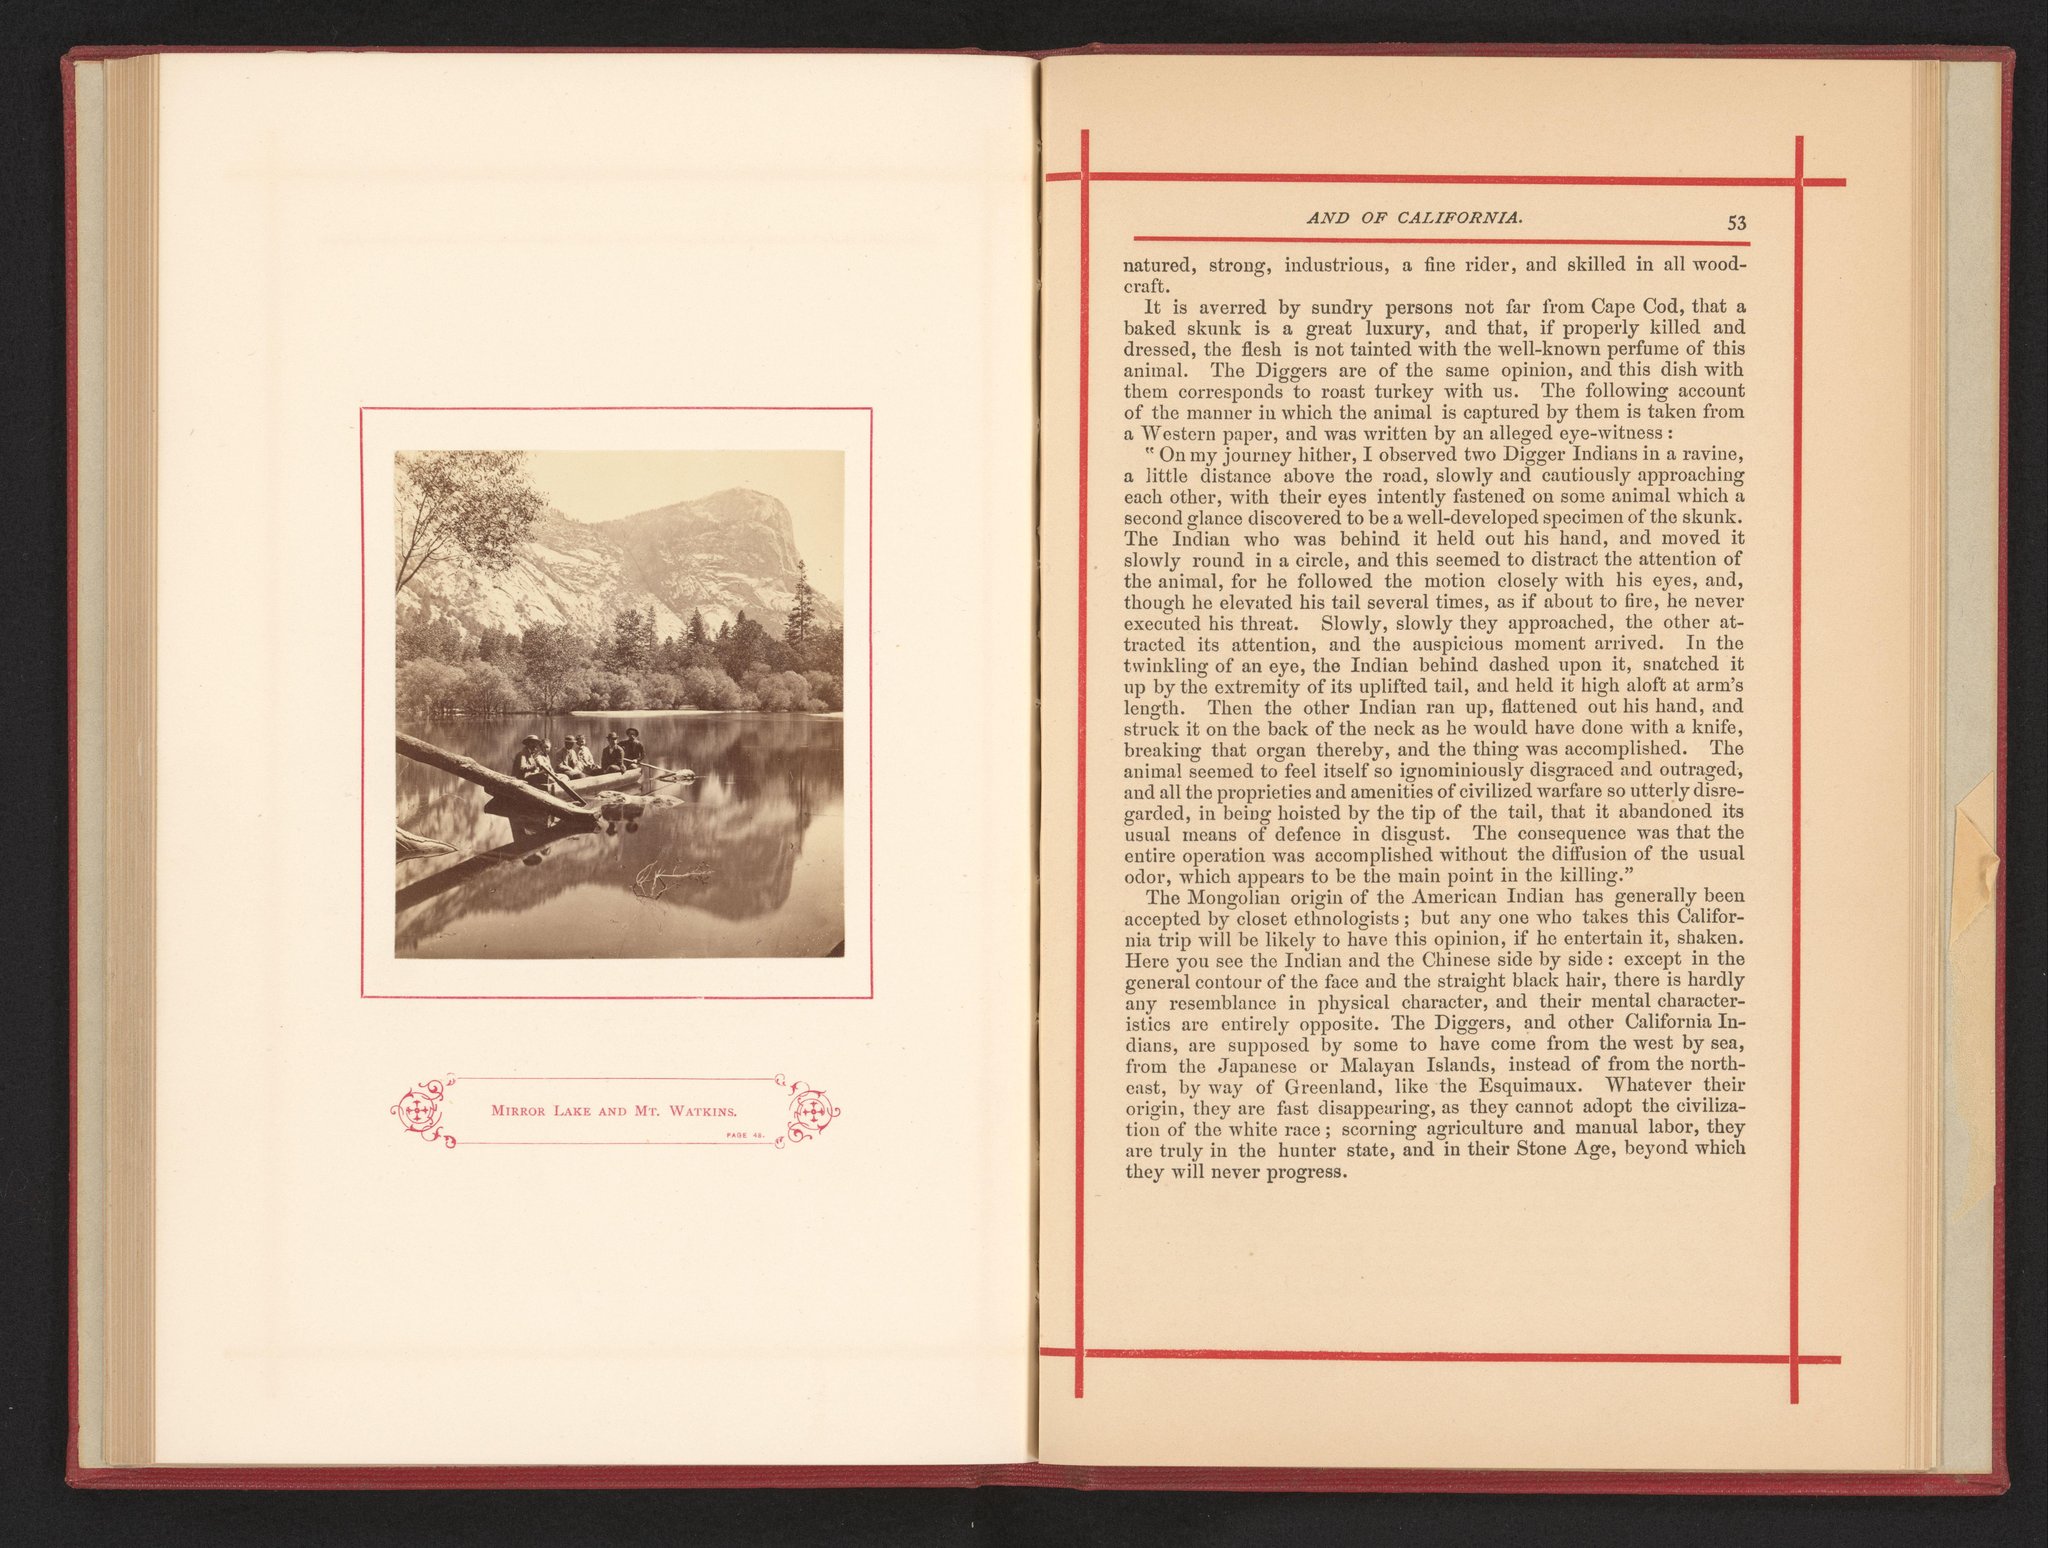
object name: page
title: Gezicht op Mount Watkins en Mirror Lake in de Yosemite Valley met een kano met zes mensen erin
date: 1861-1871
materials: photographic support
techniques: albumen print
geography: yosemite valley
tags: lake, mountains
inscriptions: inscription: ‘Page 48.’